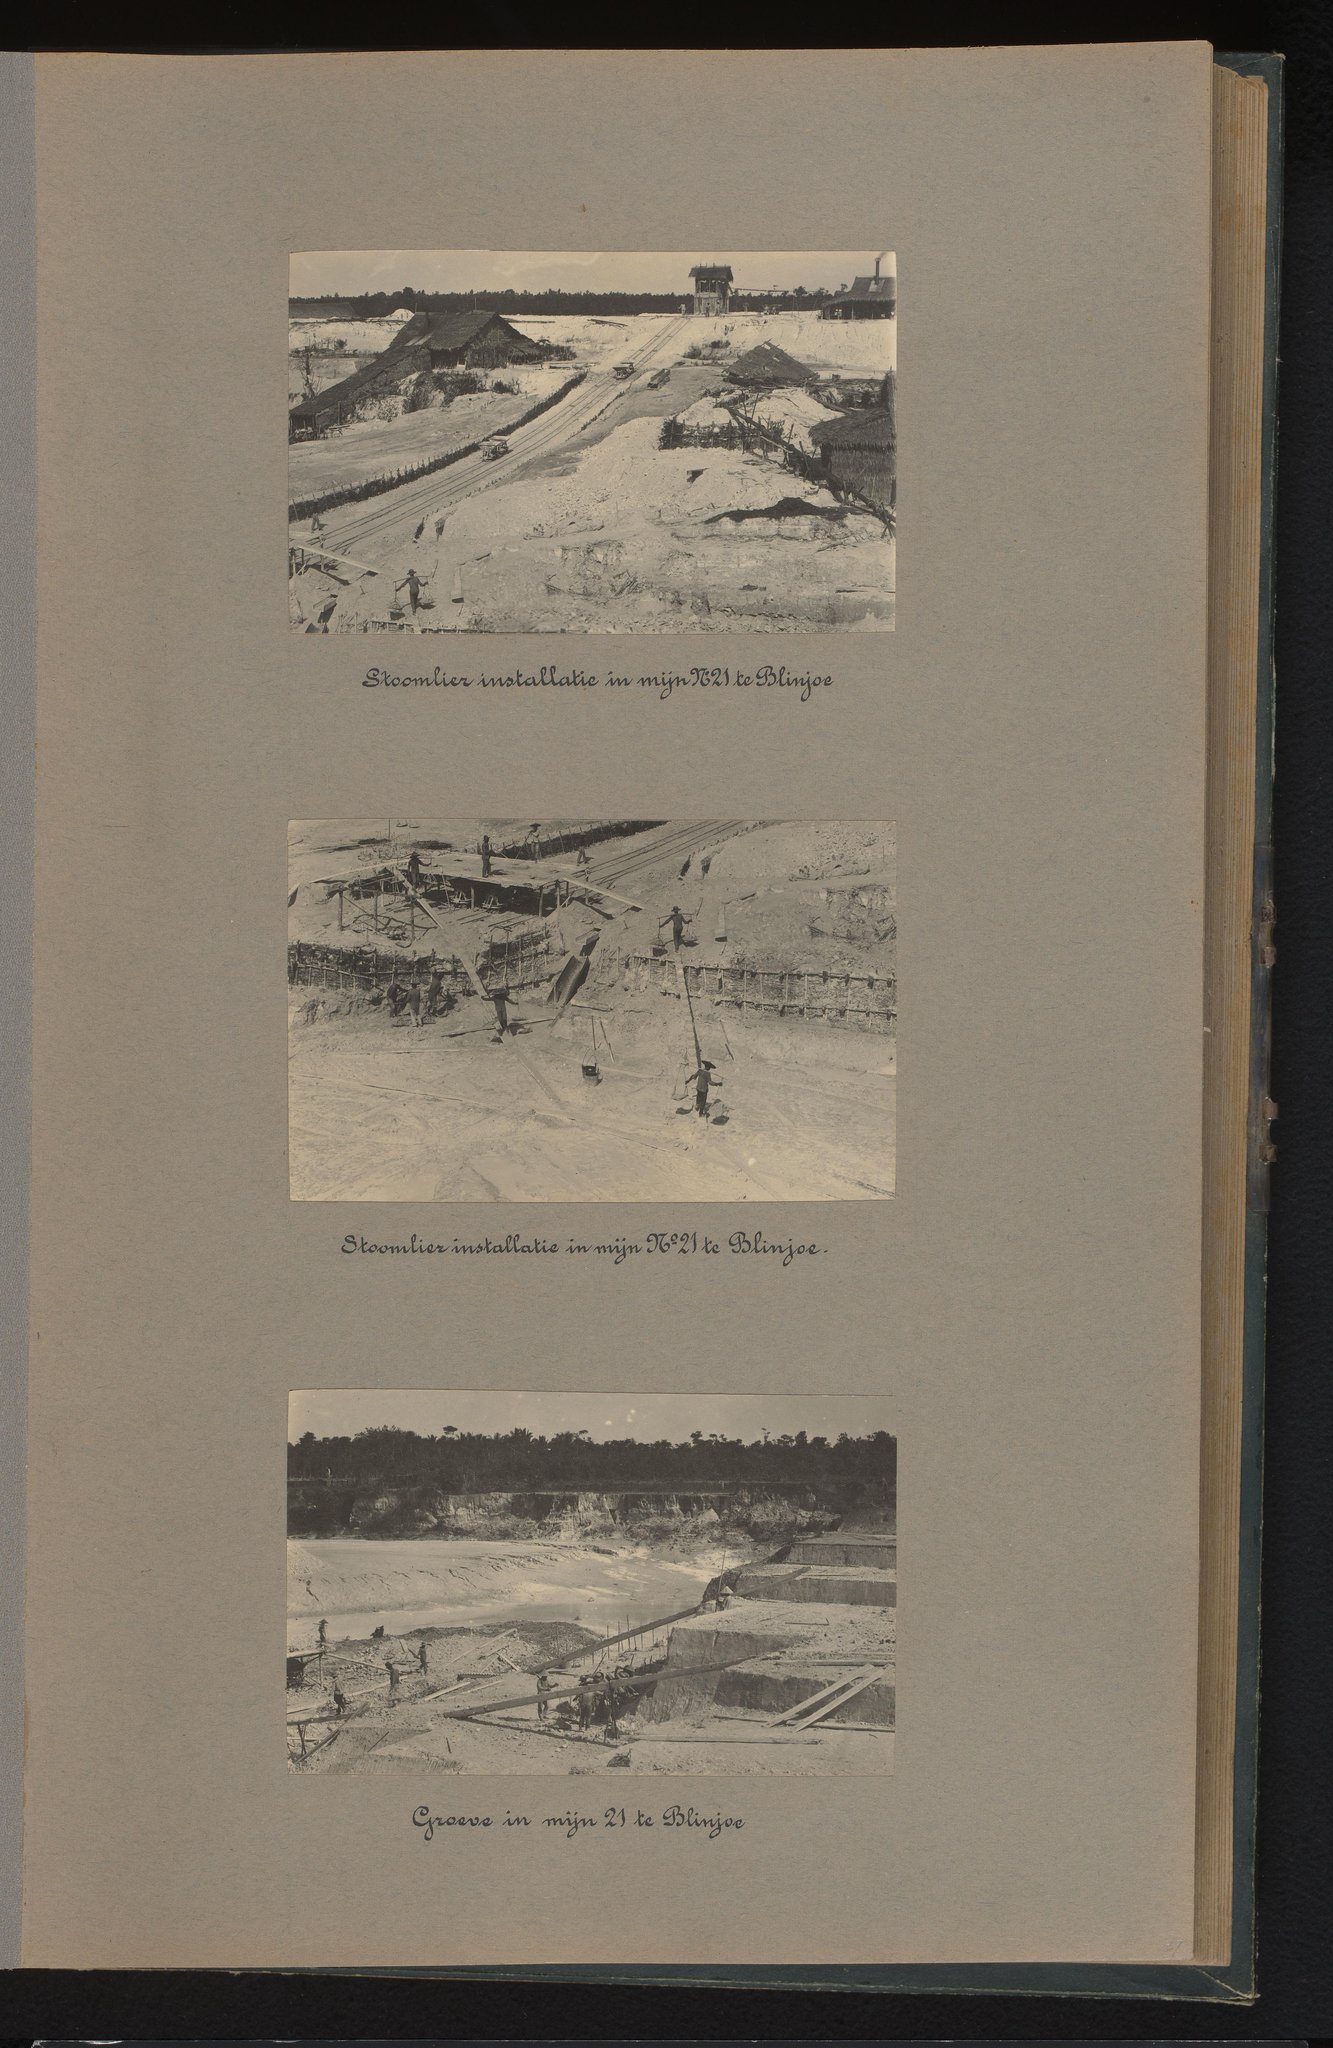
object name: photograph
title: Stoomlier en groeve in de mijnen van de Banka-tinwinning te Blinjoe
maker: Anonymous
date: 1914-1919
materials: cardboard, photographic support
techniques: gelatin silver print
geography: bangka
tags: robert julius boers, colonial system, opencast mine; strip mining, machine driven by steam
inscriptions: inscription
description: Albumblad met drie foto's van de stoomlier en een groeve in de mijnen van de Banka-tinwinning te Blinjoe. Onderdeel van het fotoalbum aangeboden aan Robert Julius Boers bij zijn vertrek naar Nederland in 1919 door het personeel van de Banka-tinwinning.